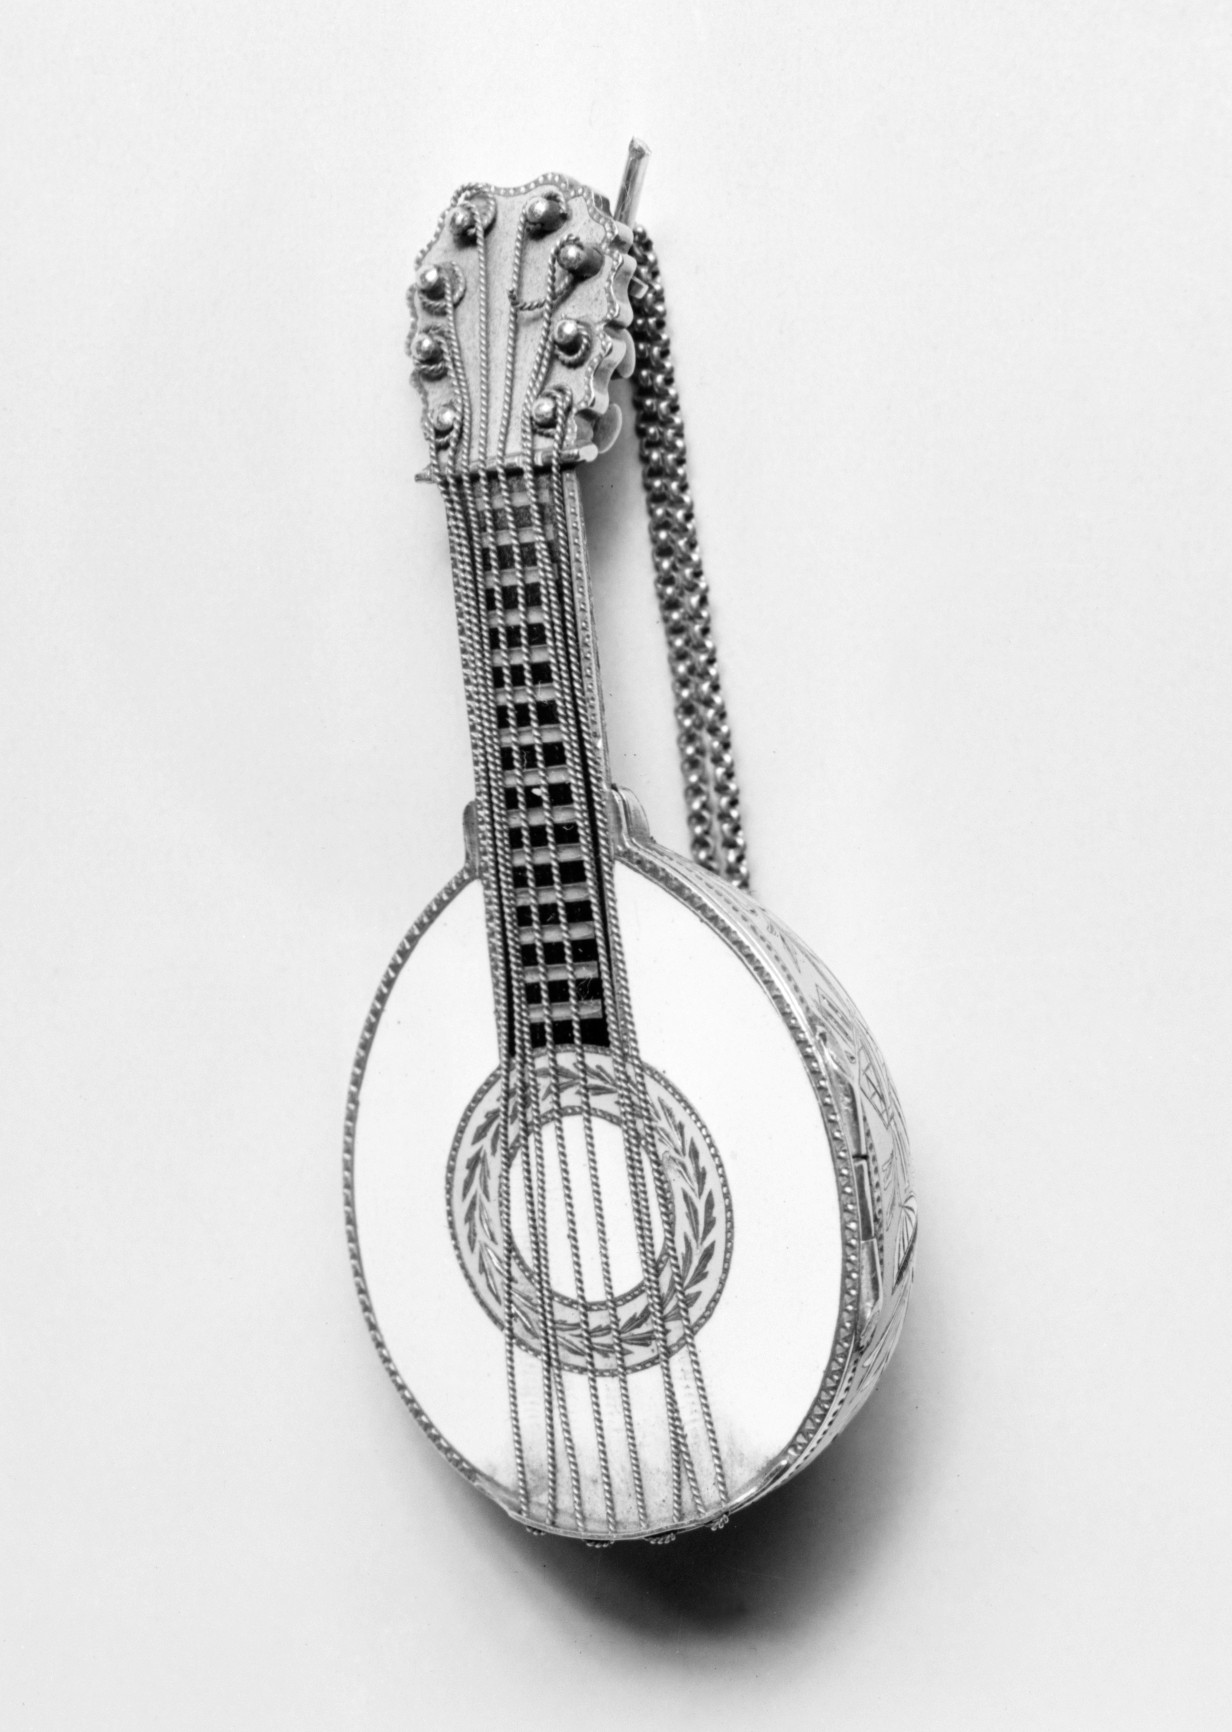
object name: watch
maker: léonard bordier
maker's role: maker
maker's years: 1800-1900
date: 1801-1900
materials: enamel, gold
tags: musical instruments